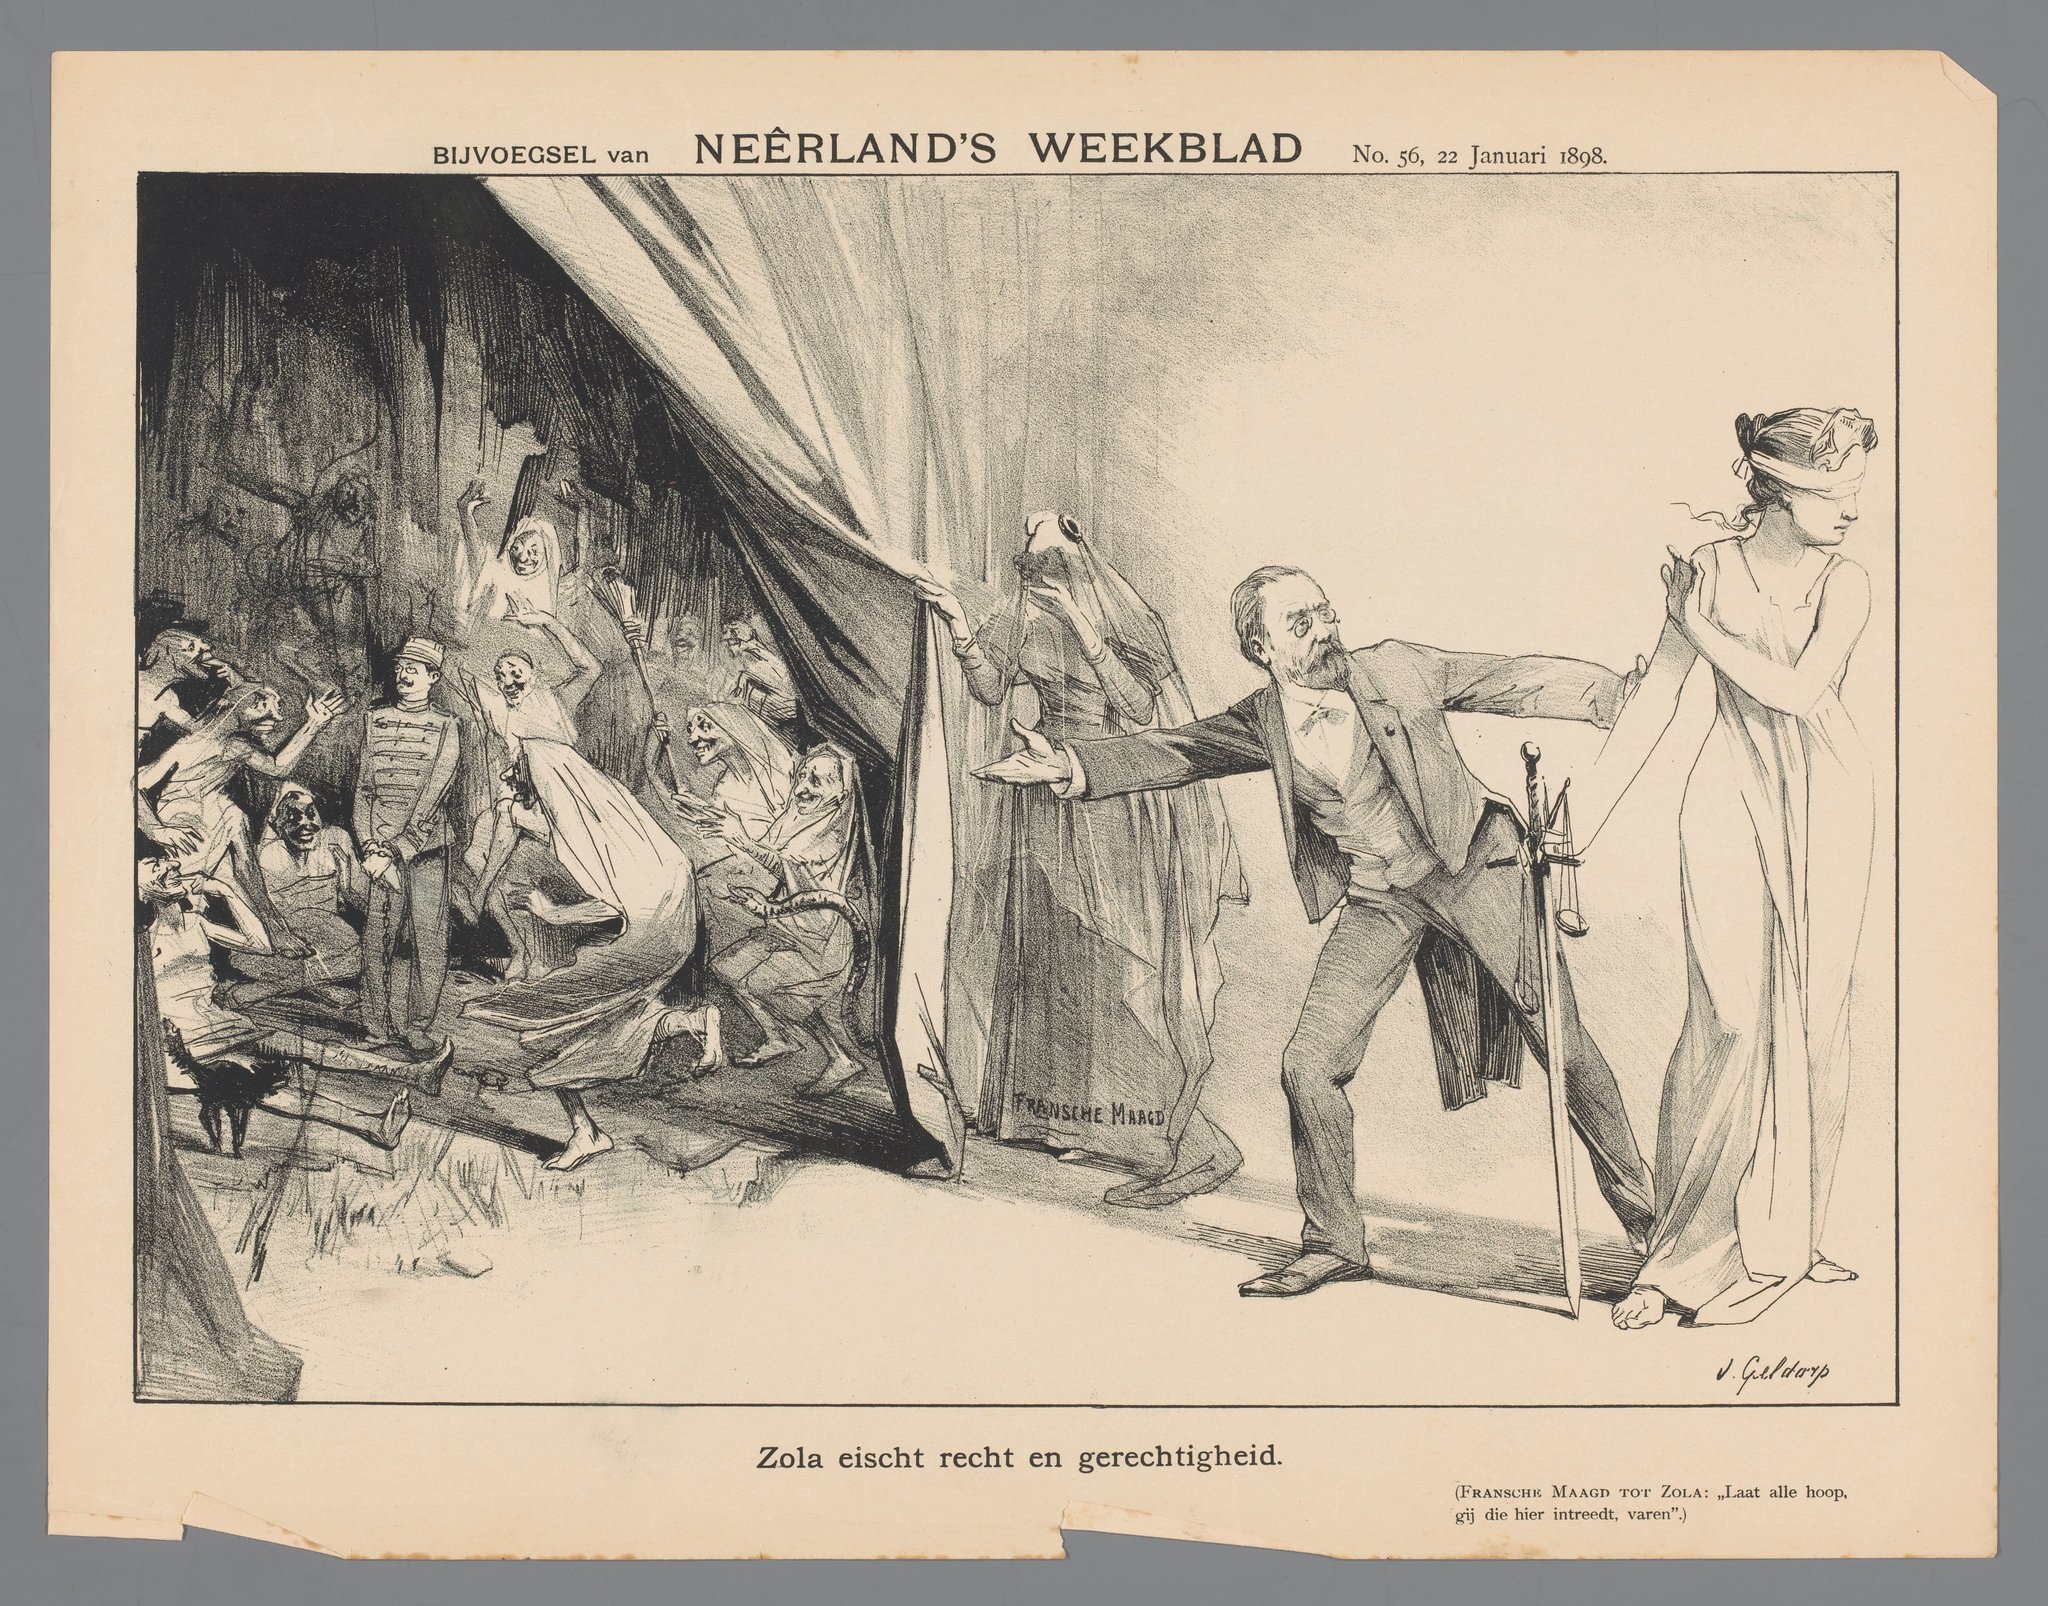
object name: cartoon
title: Zola eischt recht en gerechtigheid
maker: petrus van geldorp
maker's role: draughtsman, print maker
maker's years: 1872-1939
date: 1898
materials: paper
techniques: lithograph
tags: paris, emile zola, justitia (justice) as roman personification, political caricatures and satires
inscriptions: date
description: Prent uit het bijvoegsel van: Neêrland’s Weekblad, nr. 56, 22 januari 1898.